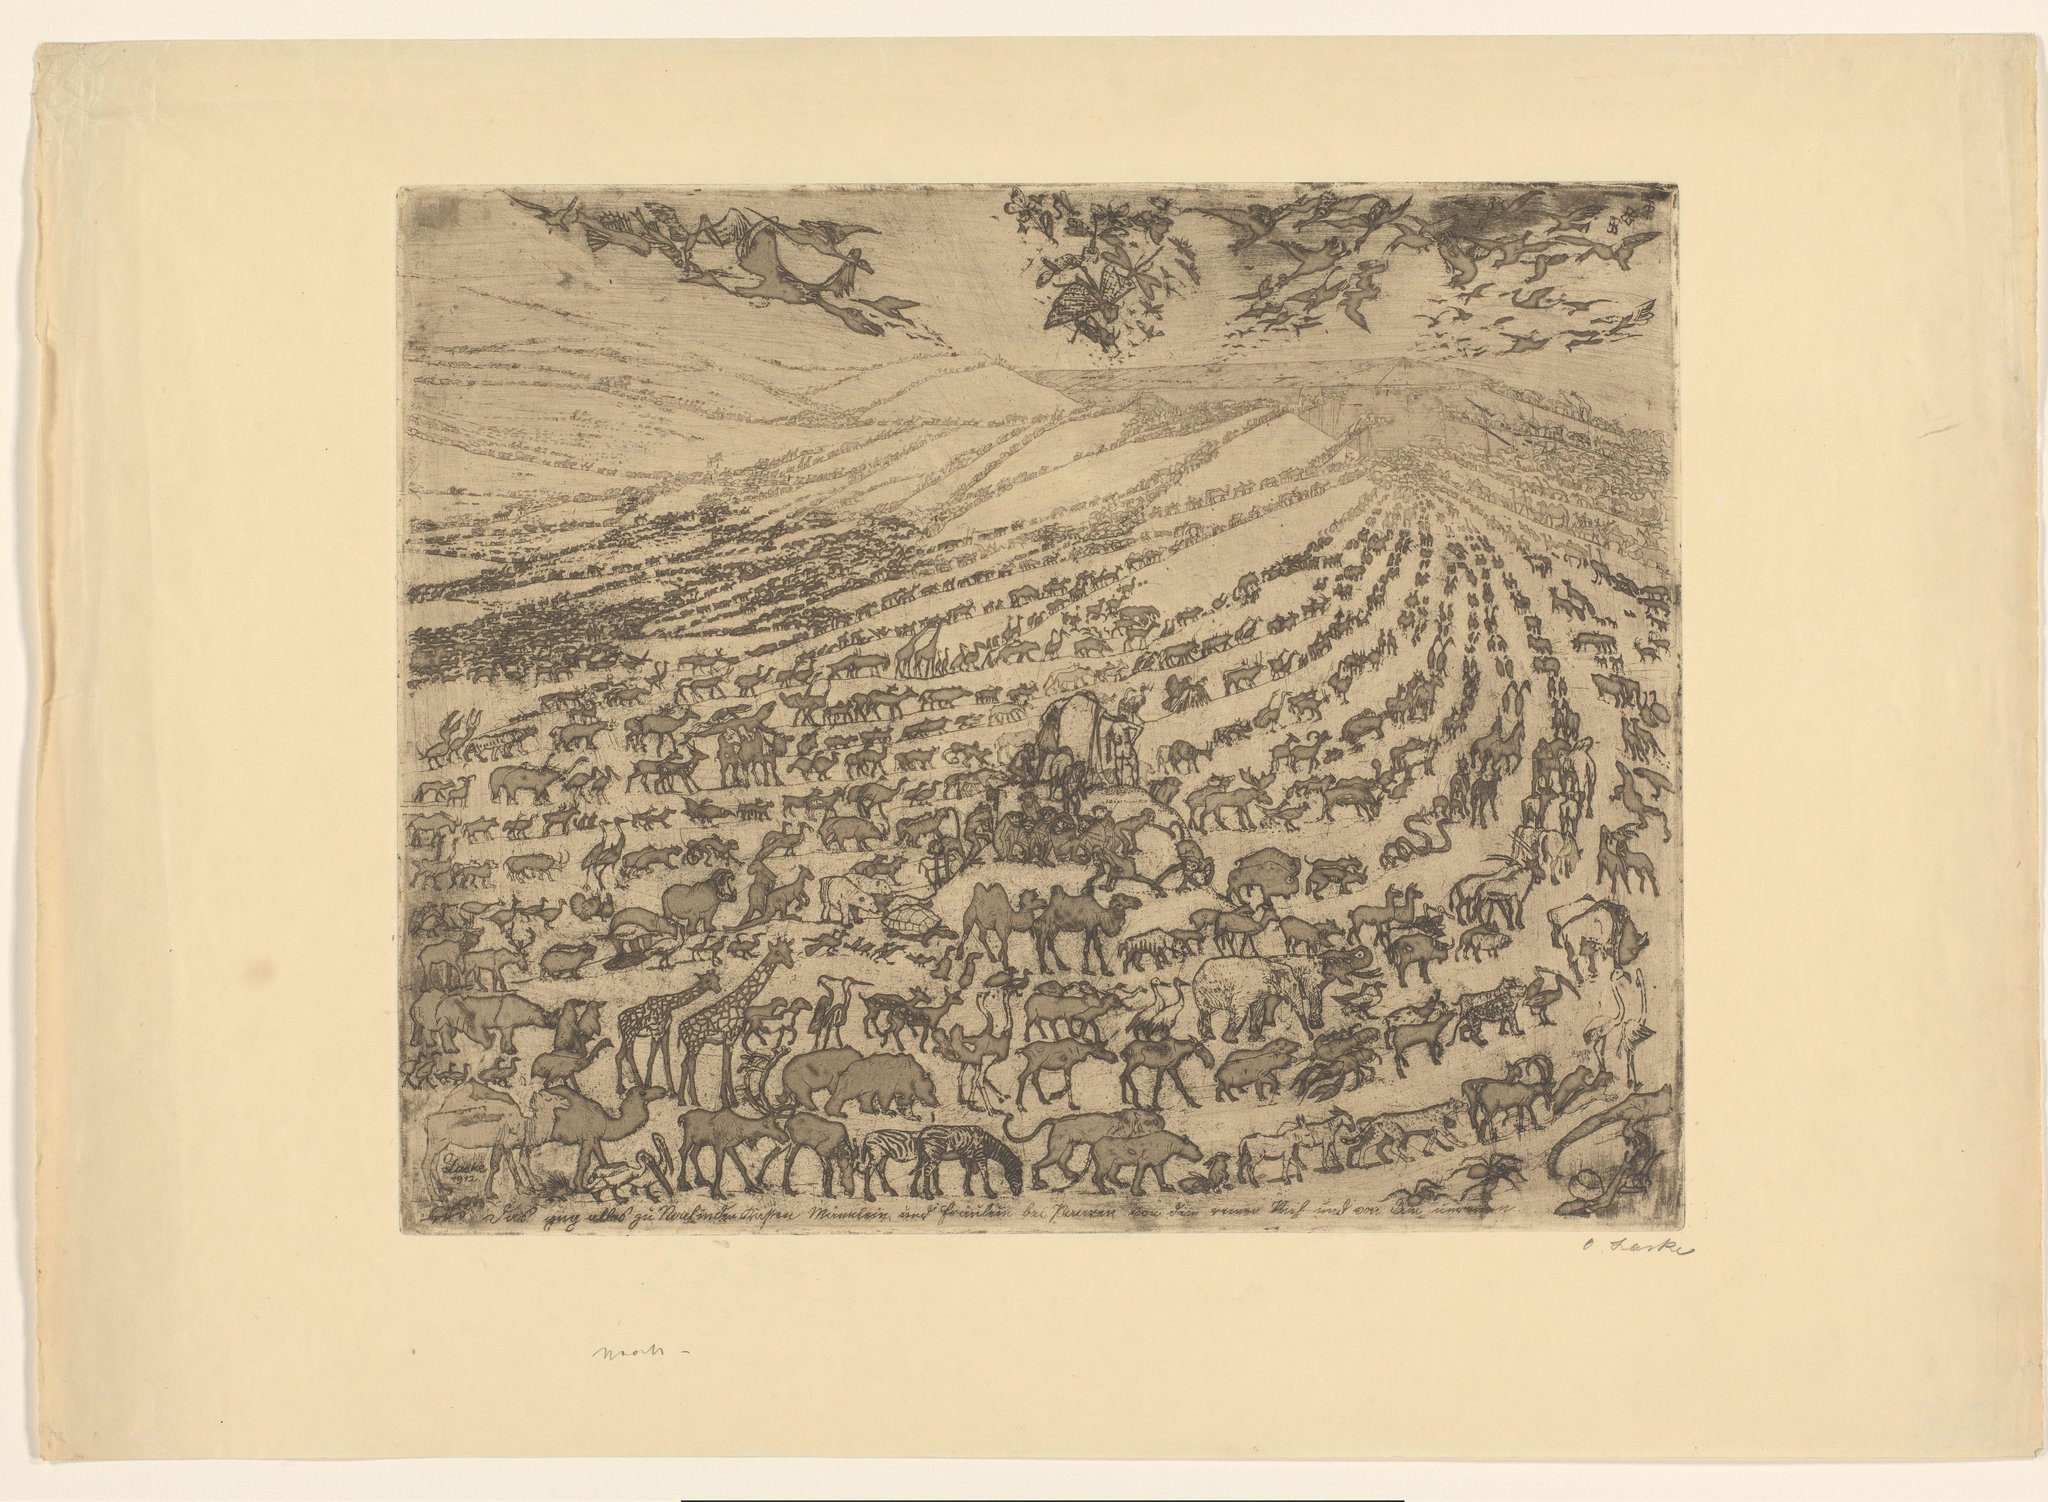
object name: print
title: Dierenkoppels trekken naar de ark van Noach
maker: oskar laske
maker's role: print maker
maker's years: 1874-1951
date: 1912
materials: paper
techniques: aquatint, etching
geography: ukraine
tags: the gathering of the animals in pairs ~ story of noah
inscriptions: annotation: ‘Noah’, collector's mark: Lugt 2228